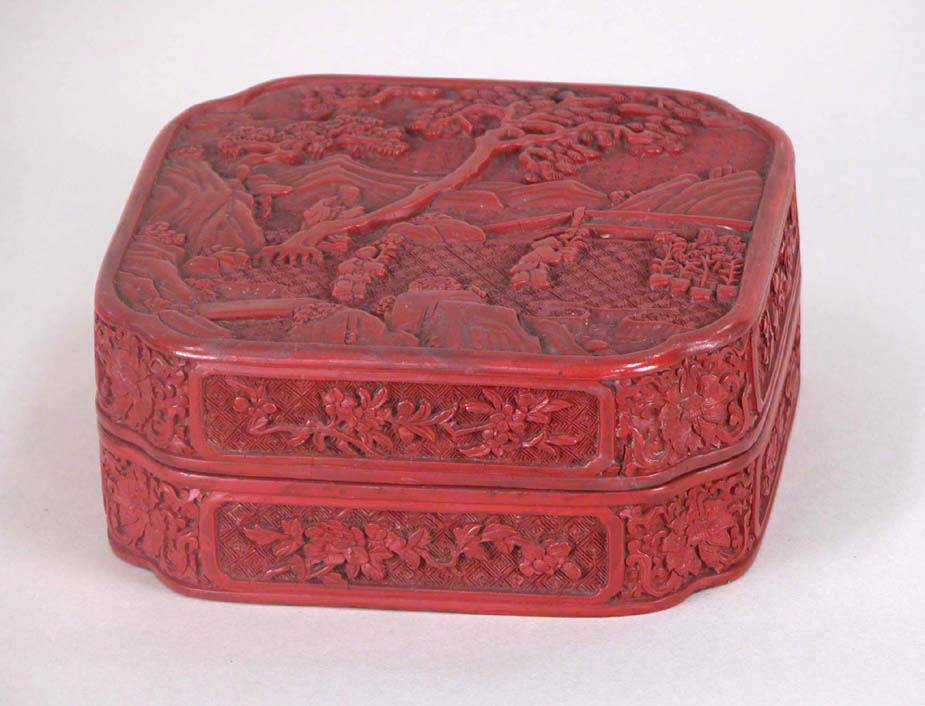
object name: box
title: Box with a scholar and chrysanthemums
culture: chinese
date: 1801-1900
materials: lacquer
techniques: carving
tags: flowers